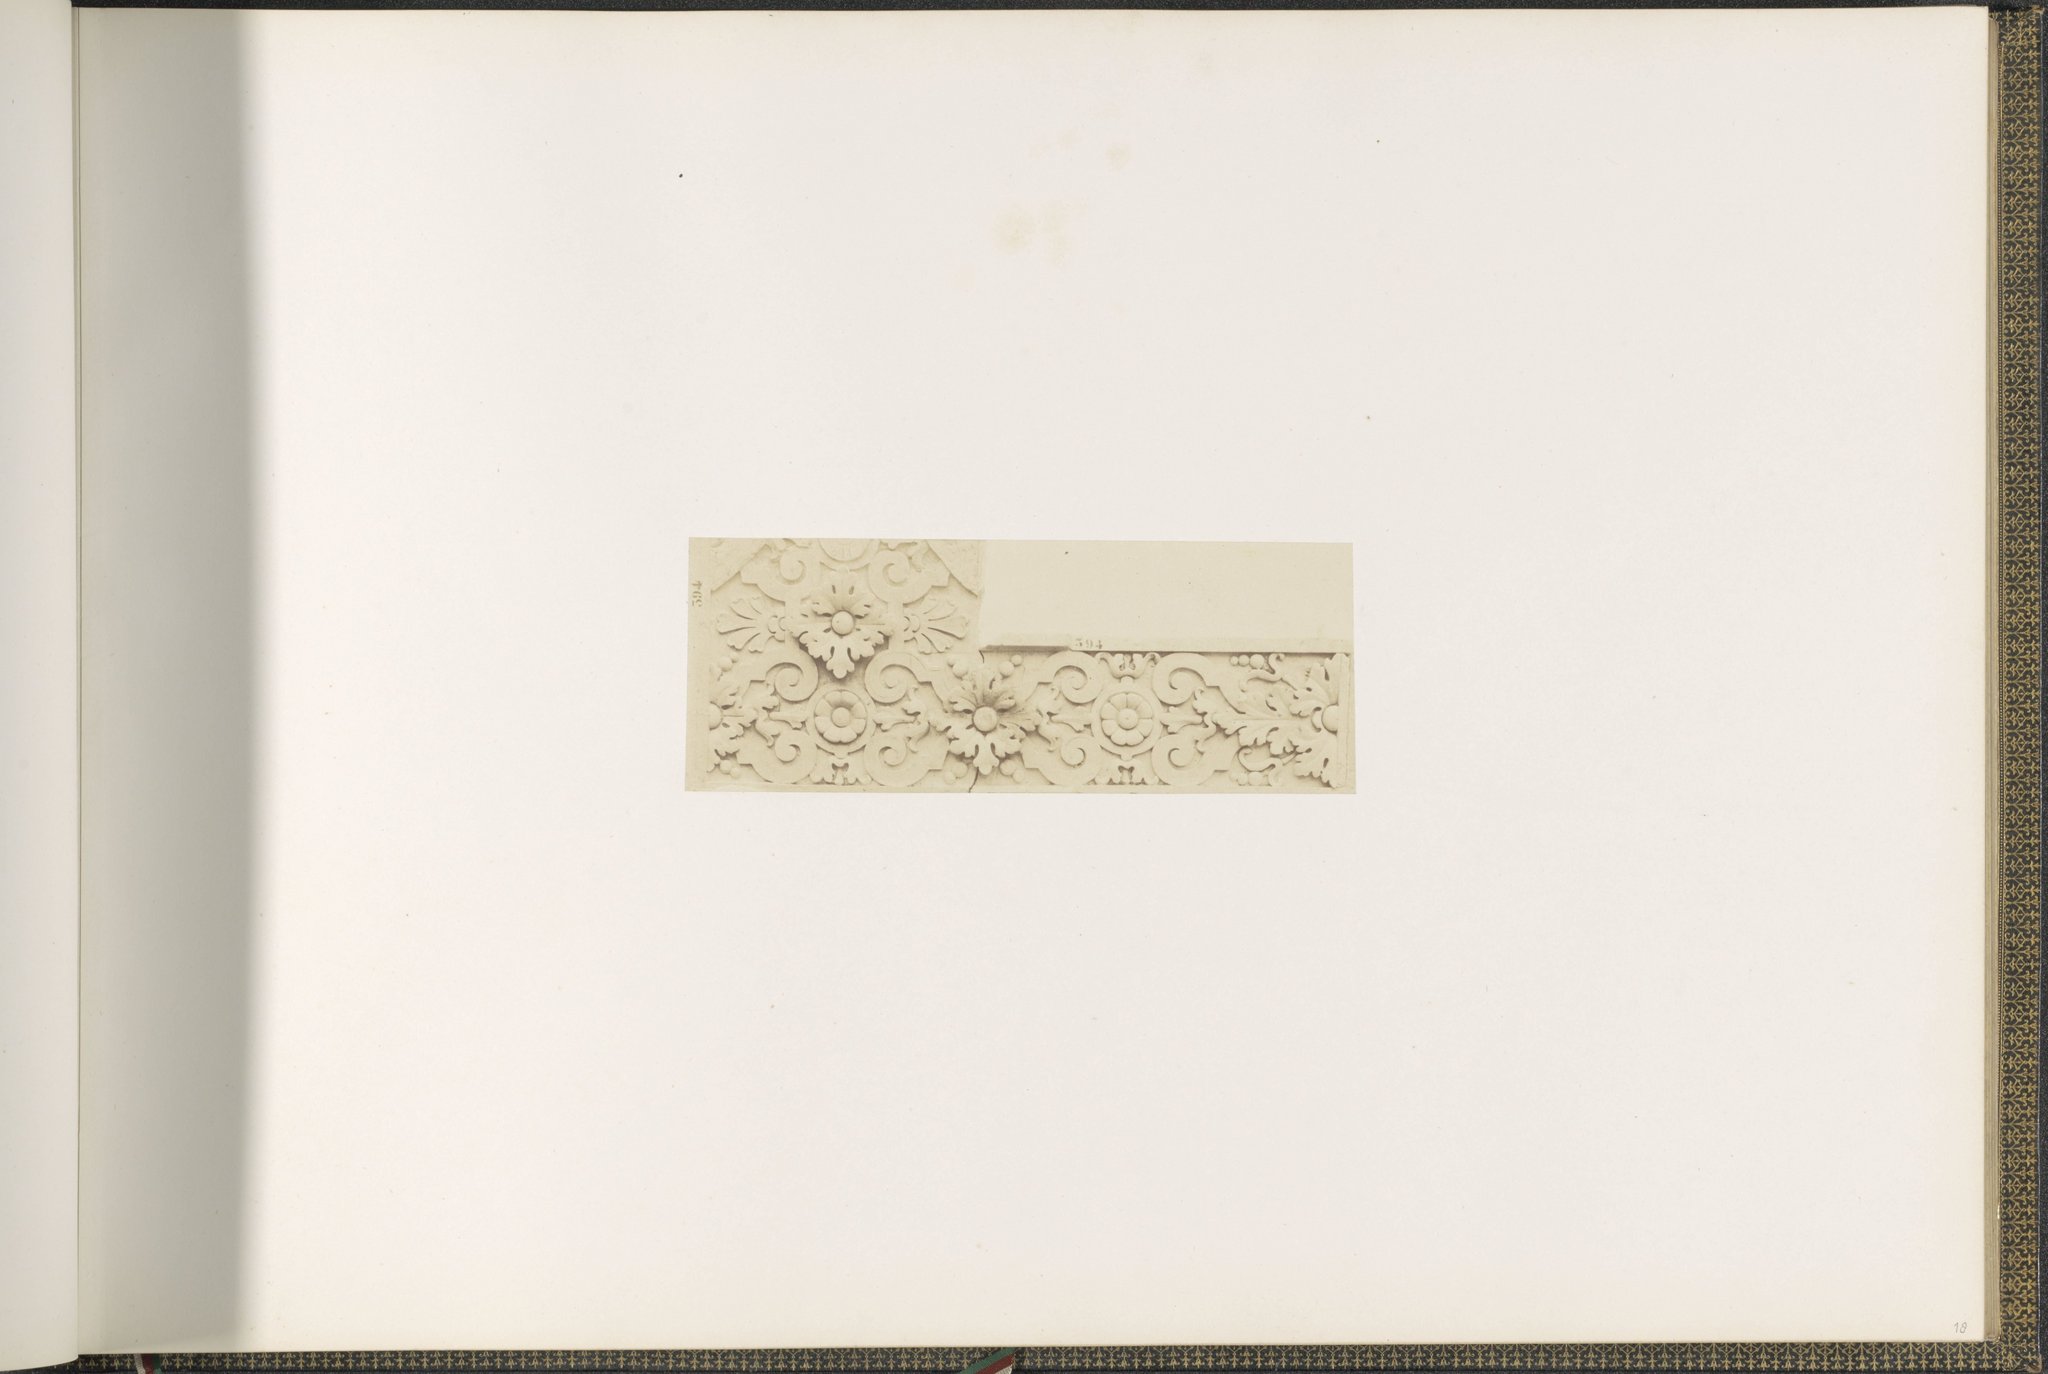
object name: photograph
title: Gipsmodel voor versiering op de Bibliothèque Impériale van het Palais du Louvre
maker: édouard denis baldus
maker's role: fotograaf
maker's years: 1813-1889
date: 1855-1857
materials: paper, photographic support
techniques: salted paper print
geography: paris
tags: permanent exhibition, museum, ornamenting, decorating ~ applied arts, paris, tuileries palace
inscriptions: number: ‘375’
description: Onderdeel van Réunion des Tuileries au Louvre 1852-1857, album 4.